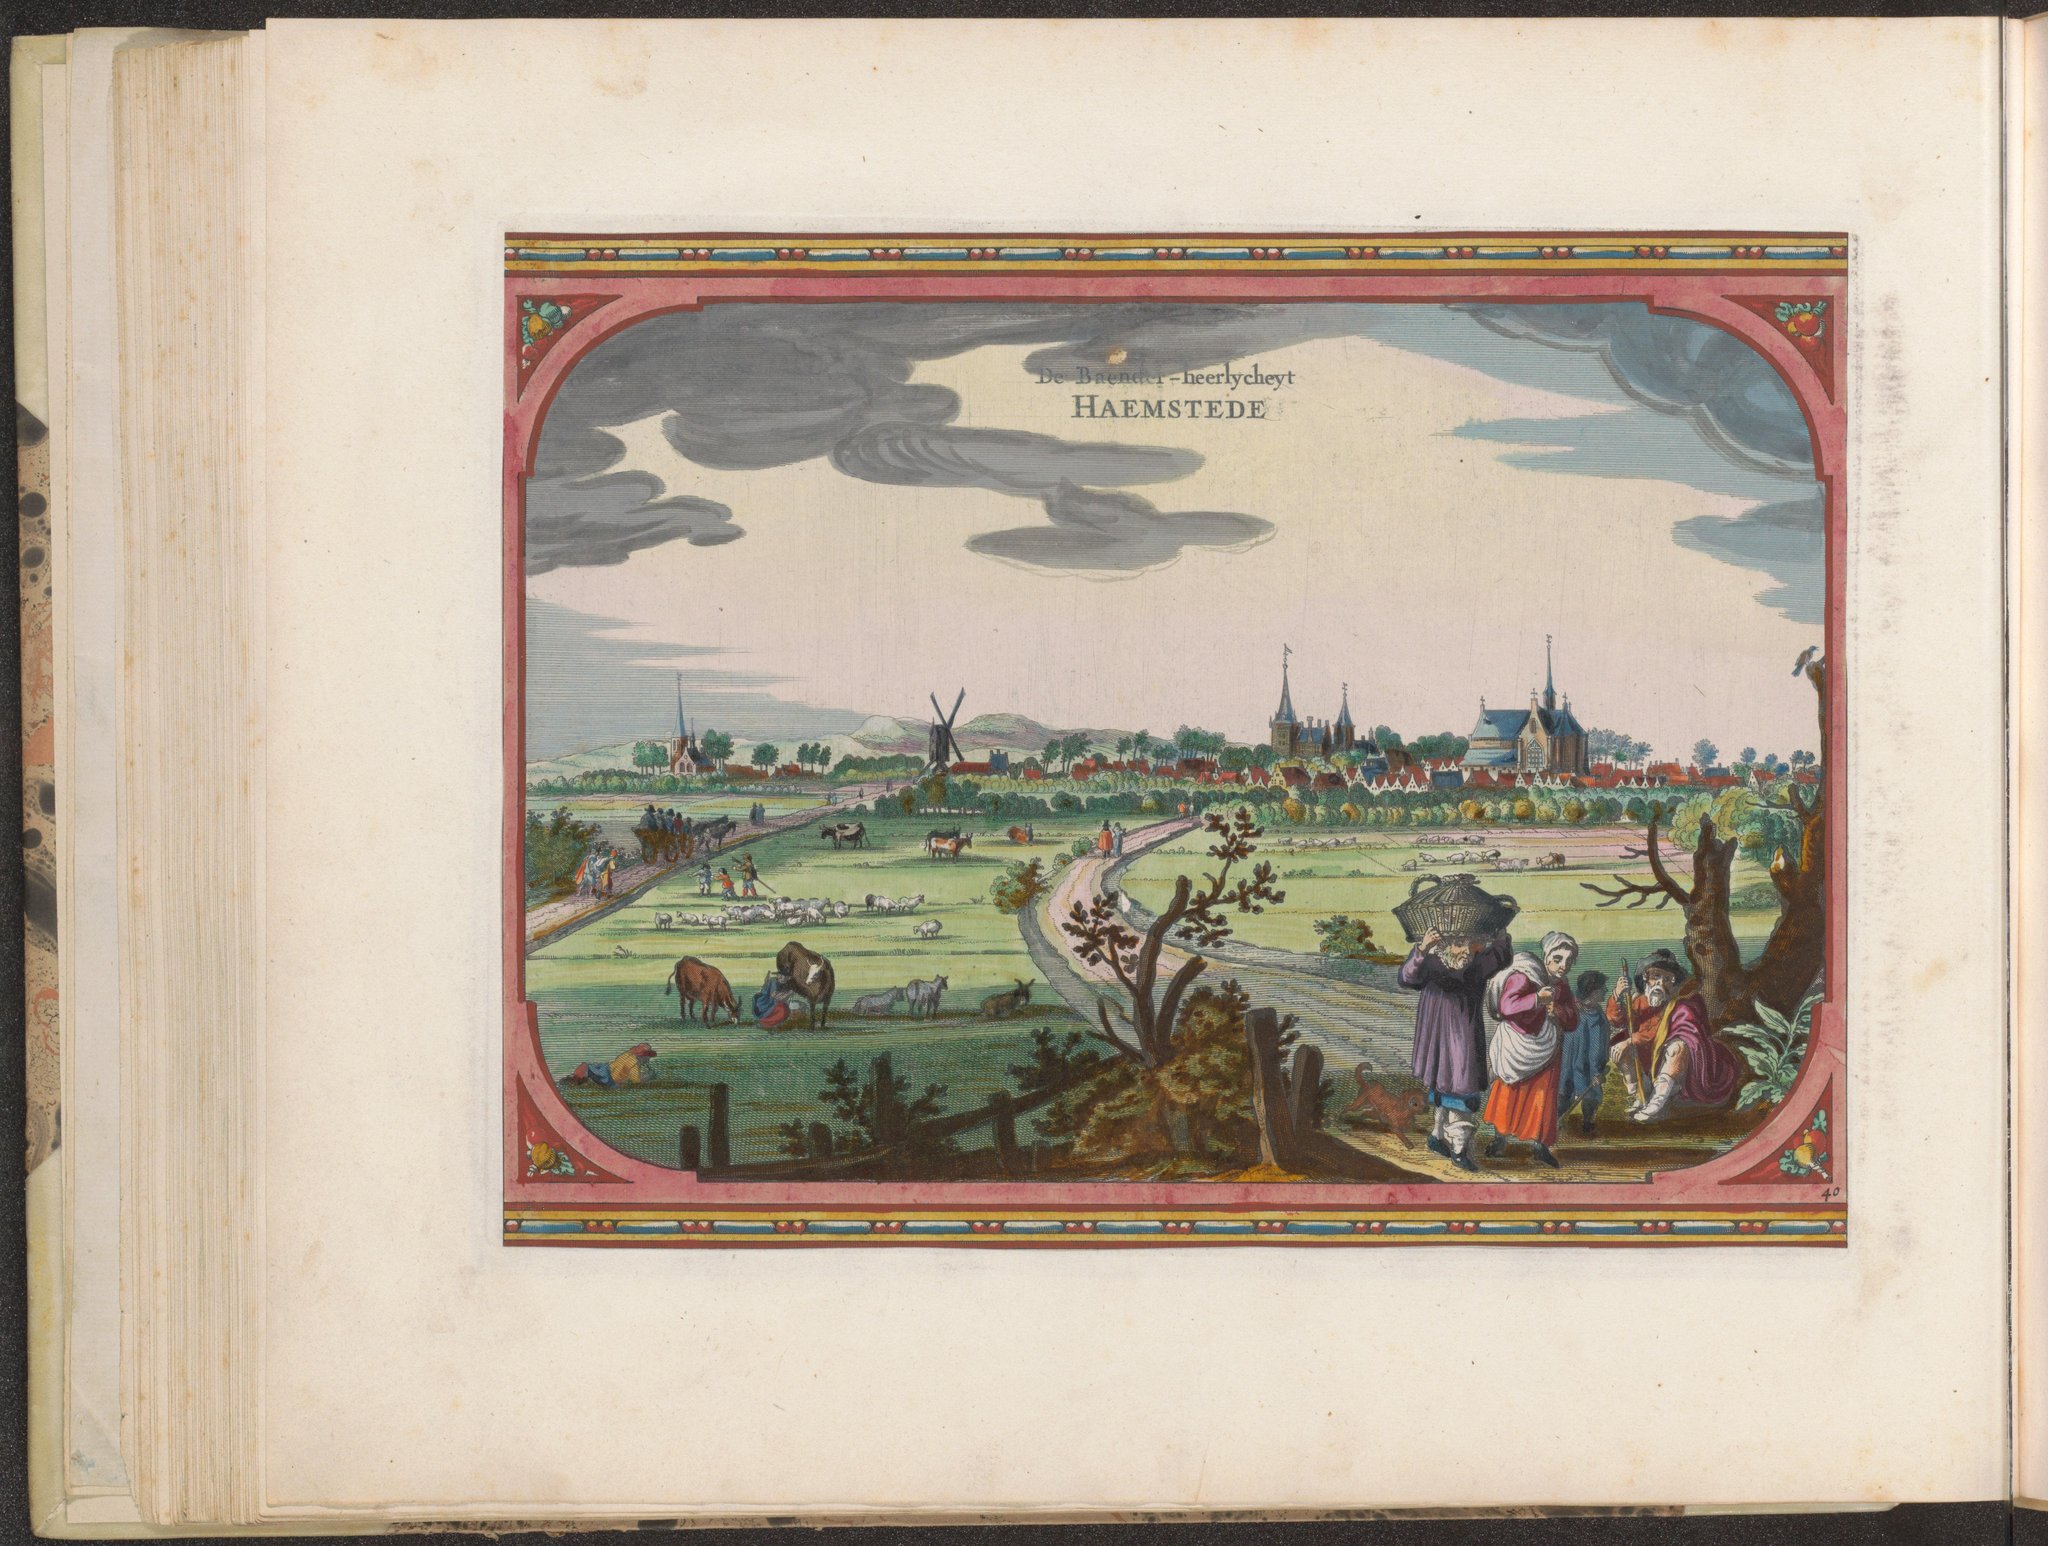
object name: album leaf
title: Theatrum praecipuarum urbium ducatus Brabantiae necnon comitatuum Flandriae et Zelandiae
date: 1662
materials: paper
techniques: etching, hand coloring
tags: city-view, and landscape with man-made constructions, carrying something, cattle, four-wheeled, animal-drawn vehicle, e.g.: cab, carriage, coach, milking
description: Gezicht op Haamstede in Zeeland en het omliggende land met vee. Op de voorgrond rechts sjouwt een man een mand op zijn hoofd. De vrouw naast hem heeft een zak over haar schouder. Bij de boom zit een oude man. Links onder meer een wagen voortgetrokken door twee paarden. In het weiland wordt een koe gemolken. De prent maakt deel uit van een album.